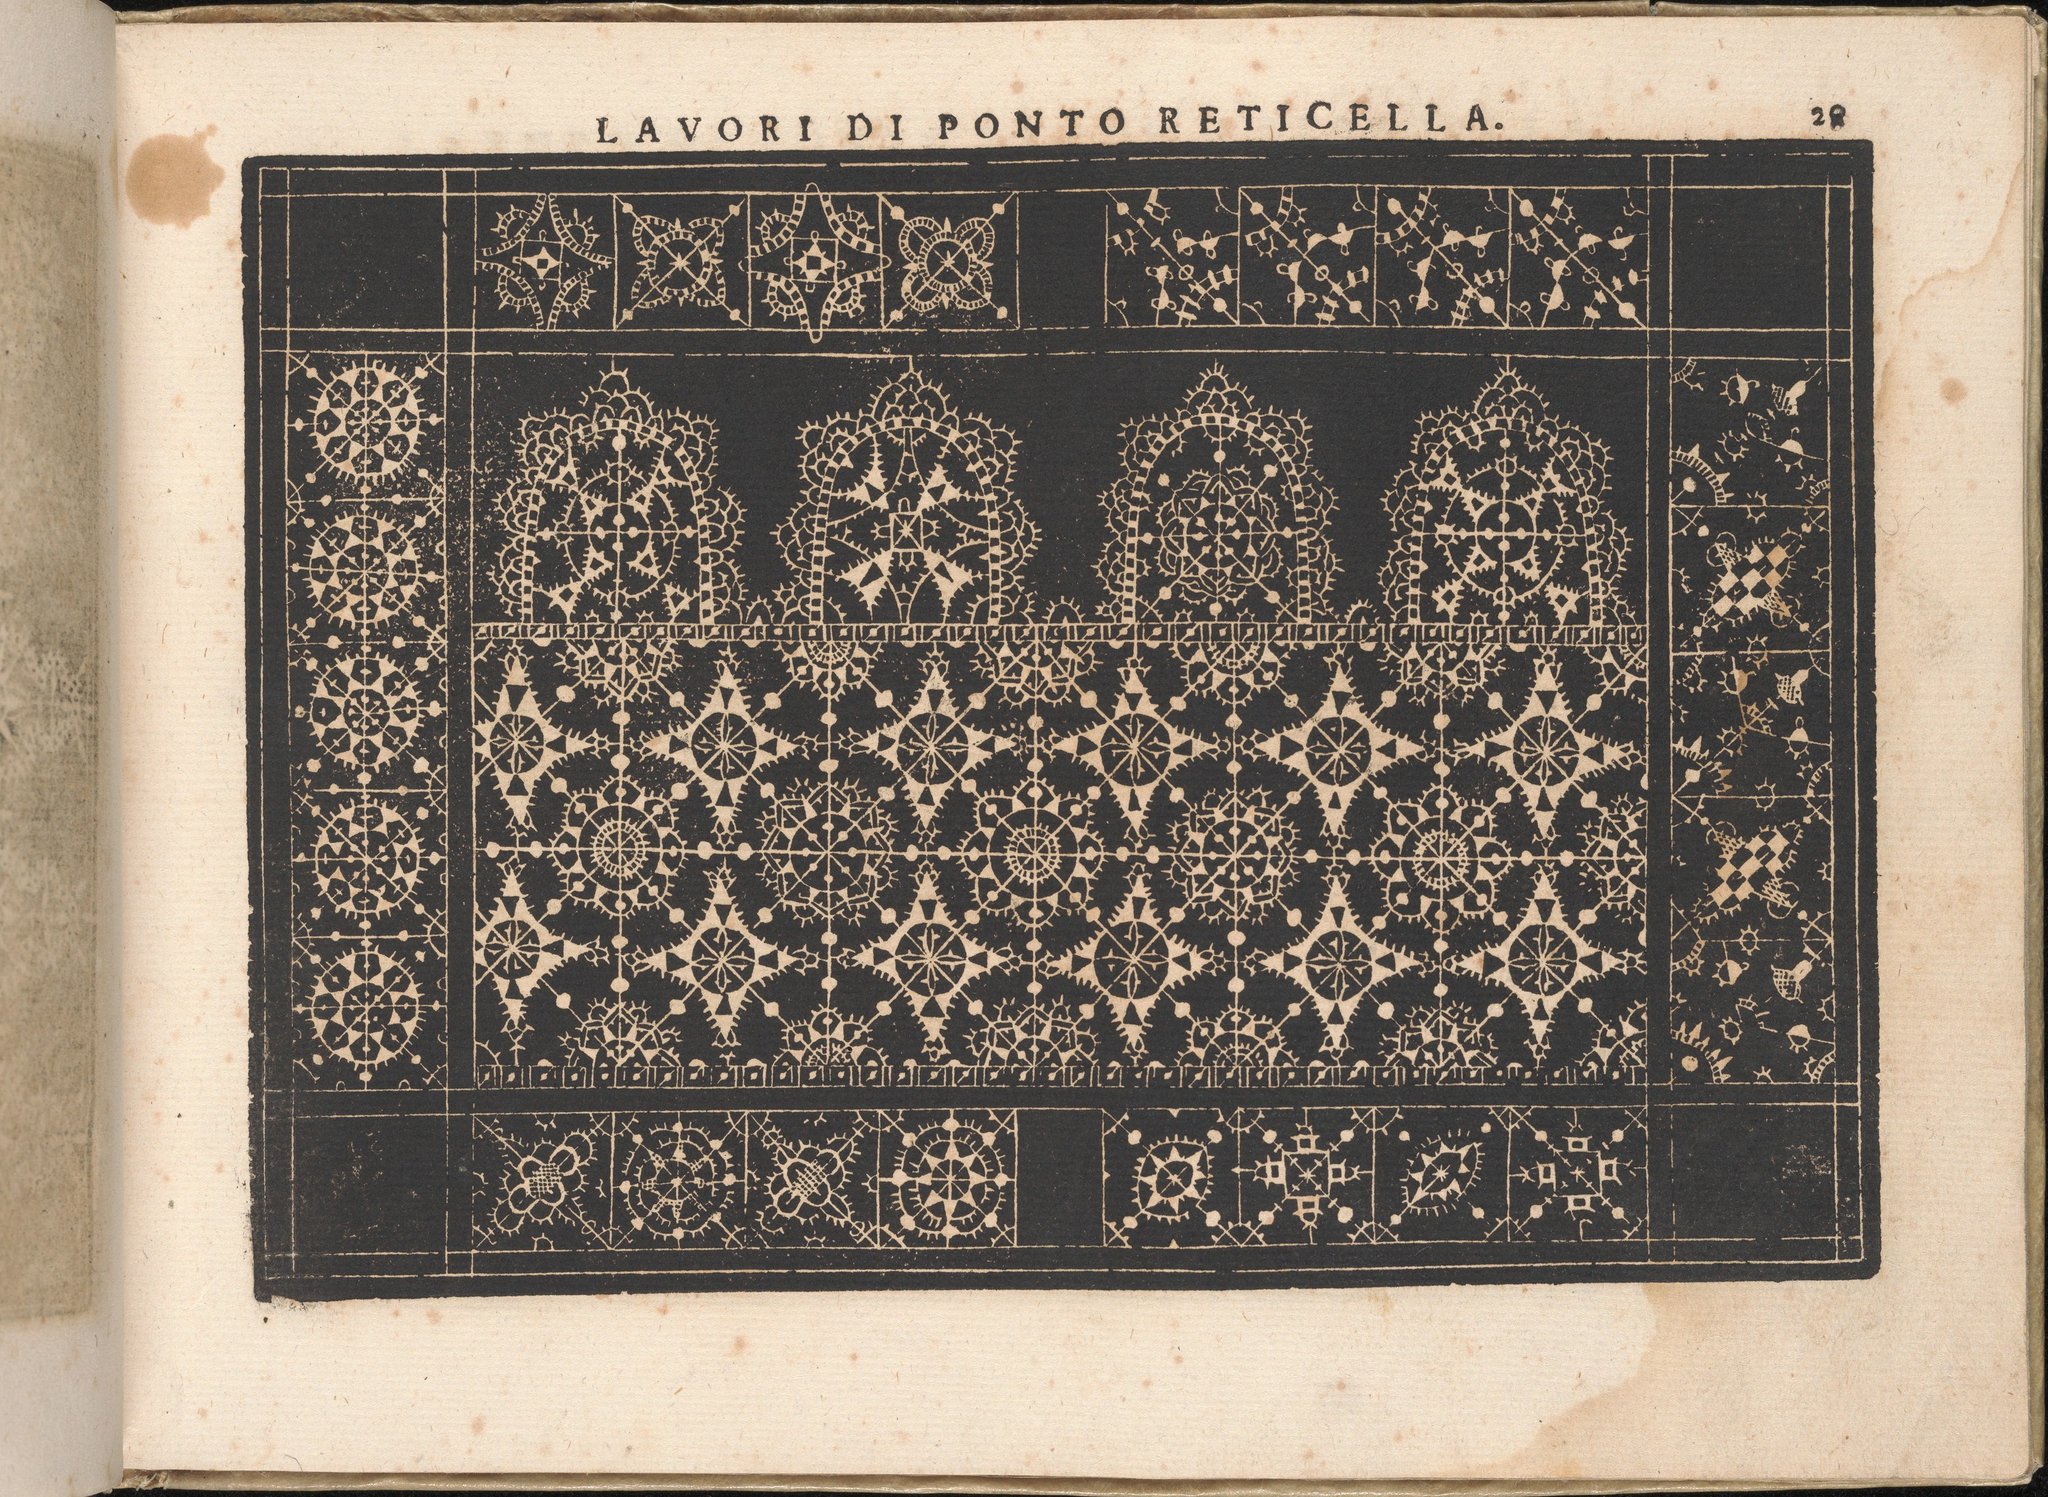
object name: book print ornament architecture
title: Fiore D'Ogni Virtu Per le Nobili Et Honeste Matrone, page 28 (recto)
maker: isabella catanea parasole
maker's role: designer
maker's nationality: italian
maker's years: 1565-1625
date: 1610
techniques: woodcut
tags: flowers